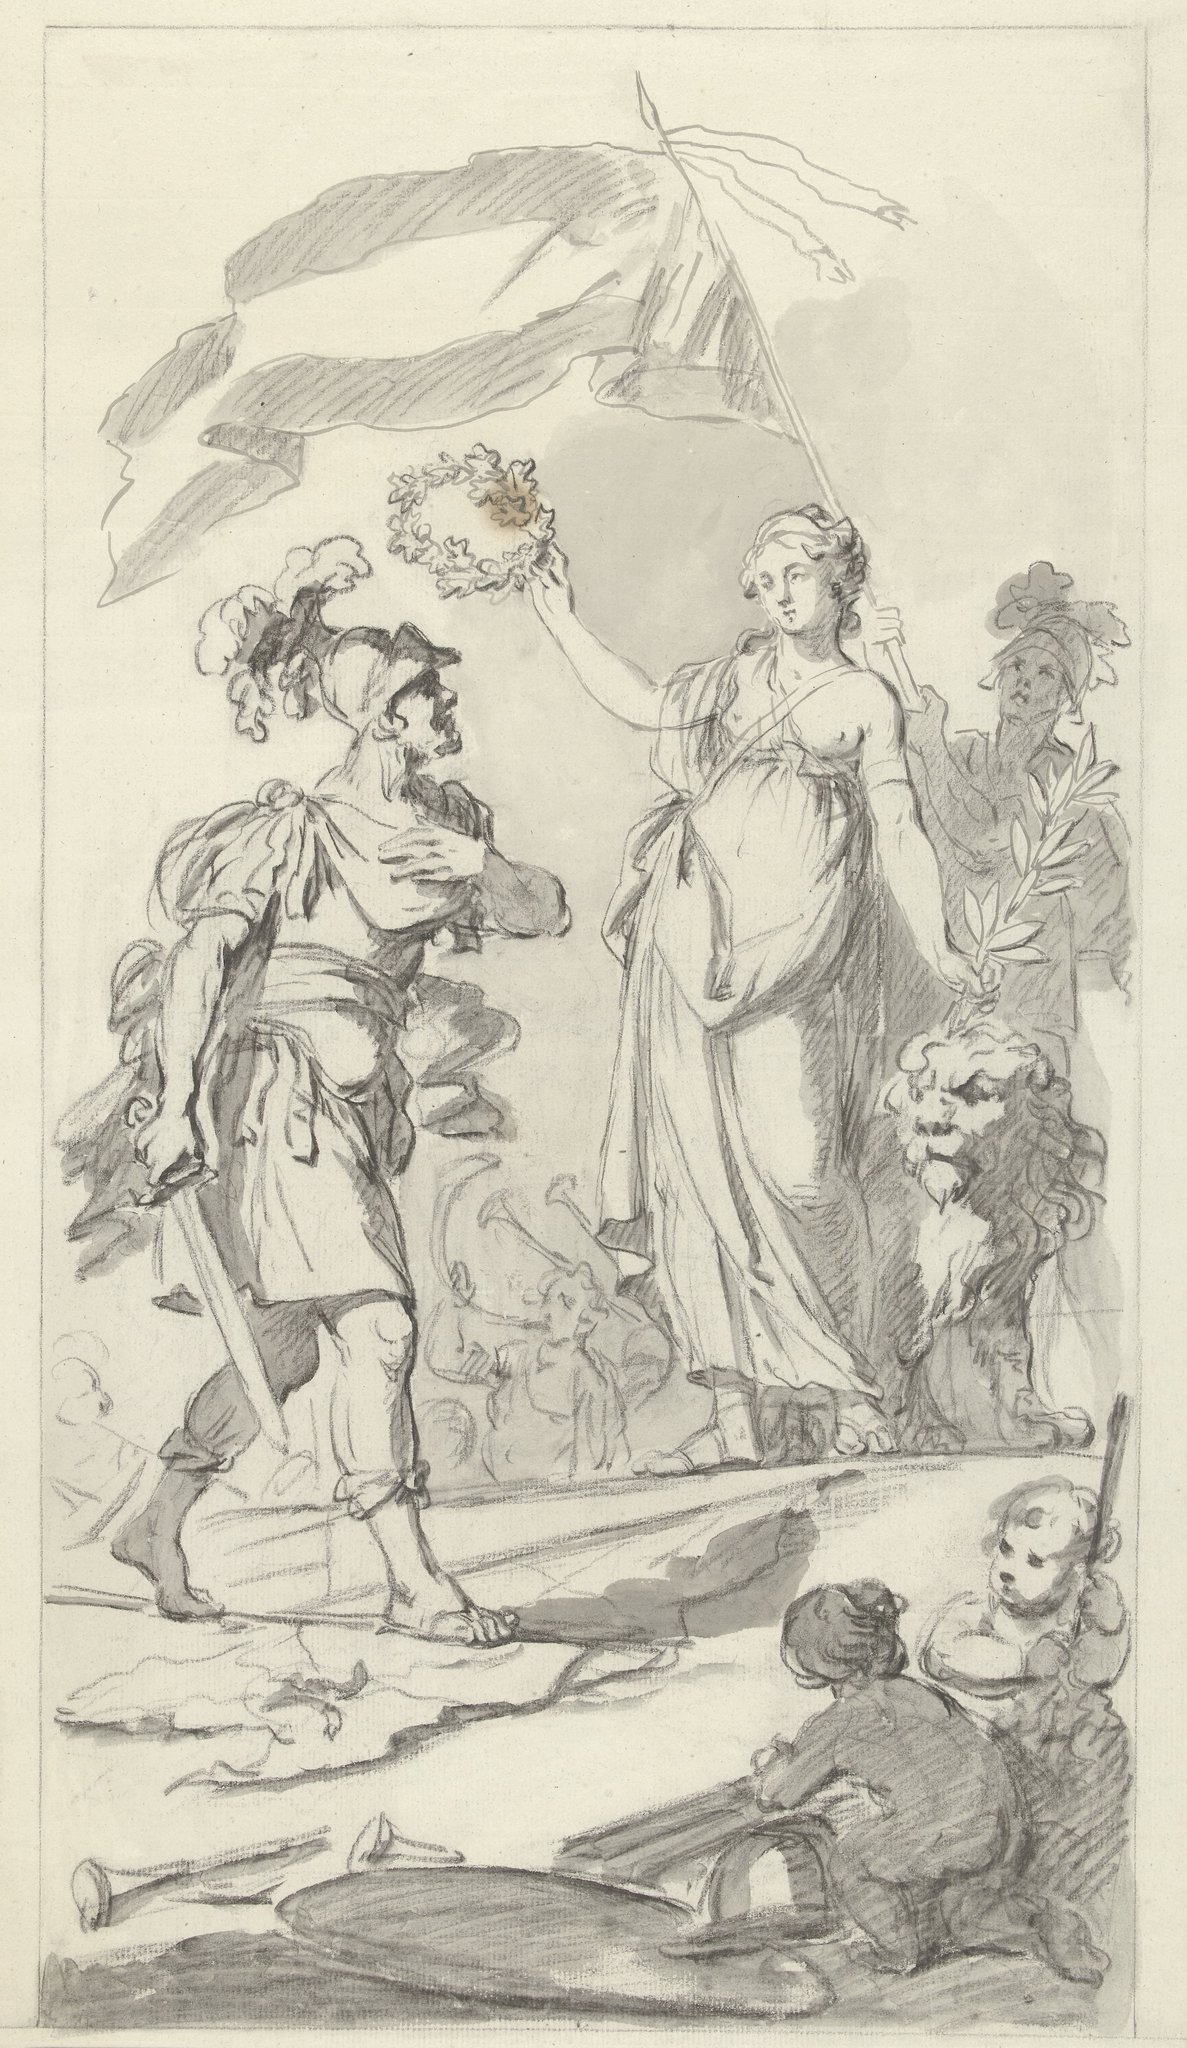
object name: drawing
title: De dappere Bataaf door de Nederlandse Maagd bekroond, 1799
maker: bartholomeus ziesenis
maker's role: draughtsman, sculptor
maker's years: 1768-1820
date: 1799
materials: chalk, paper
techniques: brush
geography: netherlands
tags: personifications of countries, nations, states, districts, etc., monument, statue, historical events and situations